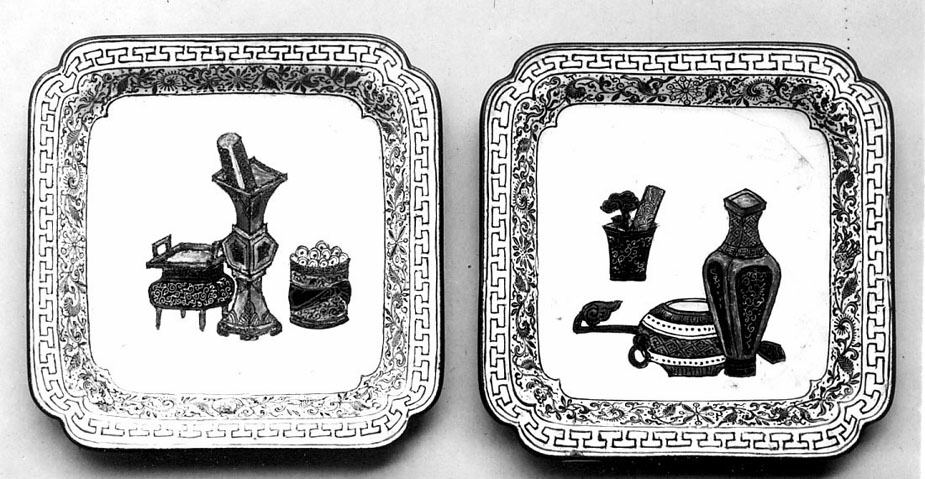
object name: dish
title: Square Dish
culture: chinese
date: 1736-1795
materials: enamel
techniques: painting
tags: vessels